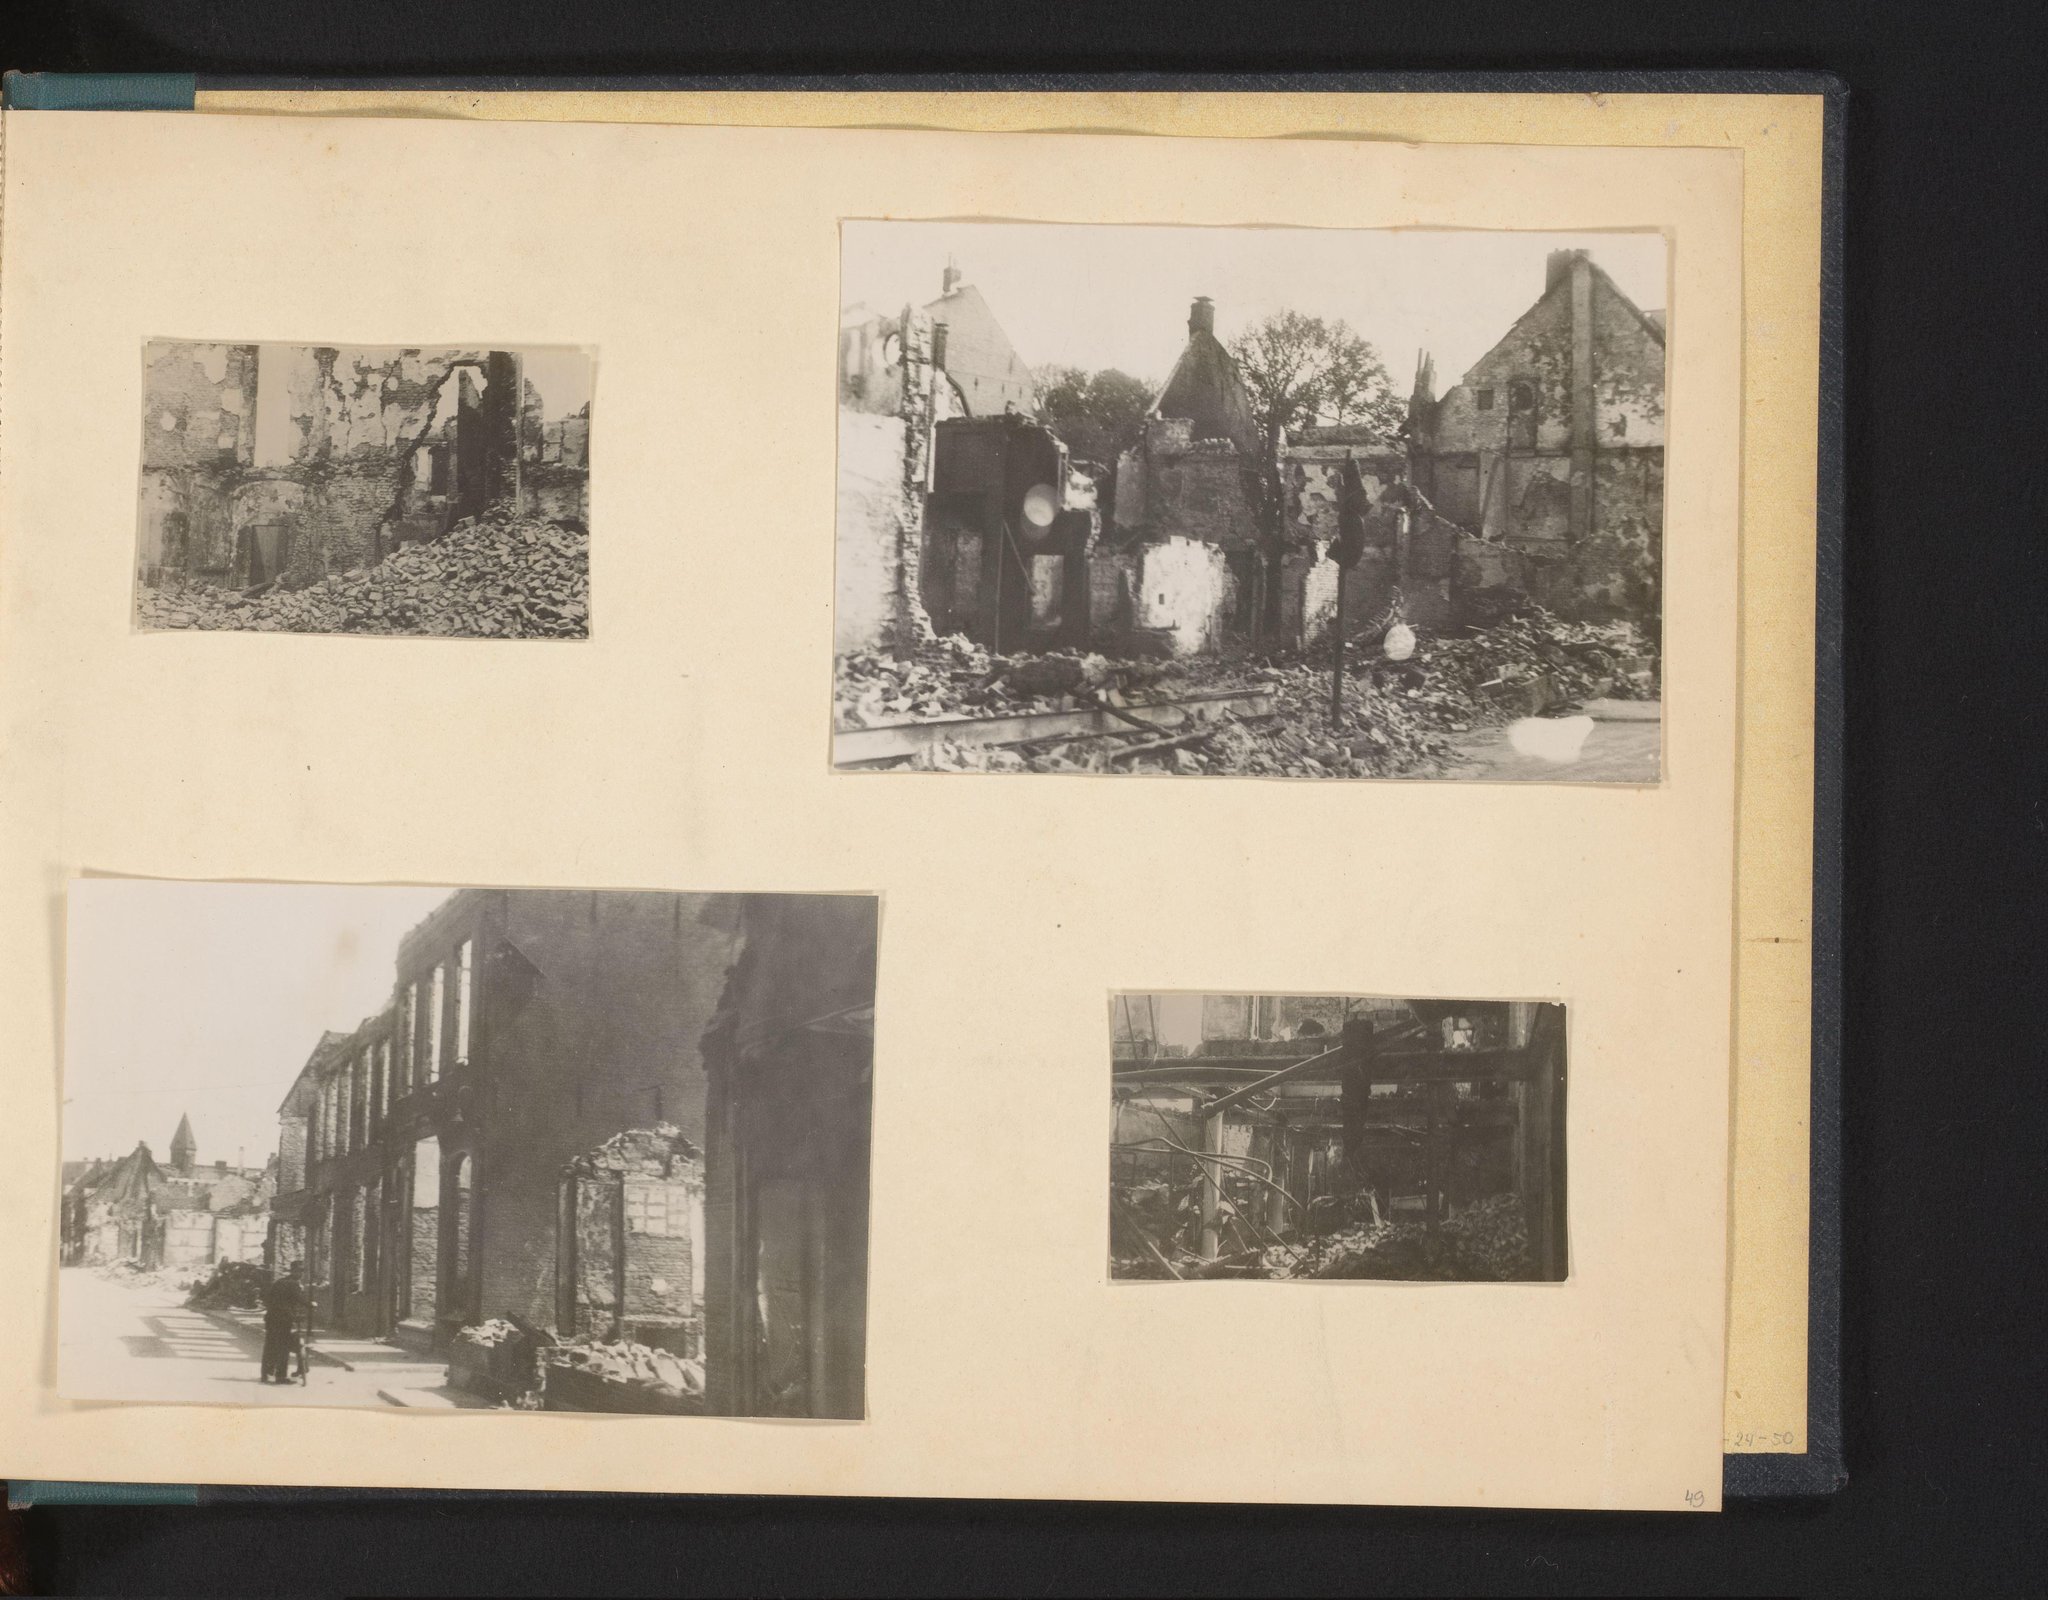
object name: photograph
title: Verwoestingen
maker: Anonymous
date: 1940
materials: cardboard, photographic support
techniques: gelatin silver print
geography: rhenen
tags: devastated, ruined place or city (~ warfare), rhenen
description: Albumblad met vier foto's van verwoeste straten en gebouwen, waarschijnlijk Rhenen in mei 1940. Onderdeel van het fotoalbum over de verwoestingen van Nederlandse steden en infrastructuur in het begin van de Tweede Wereldoorlog.